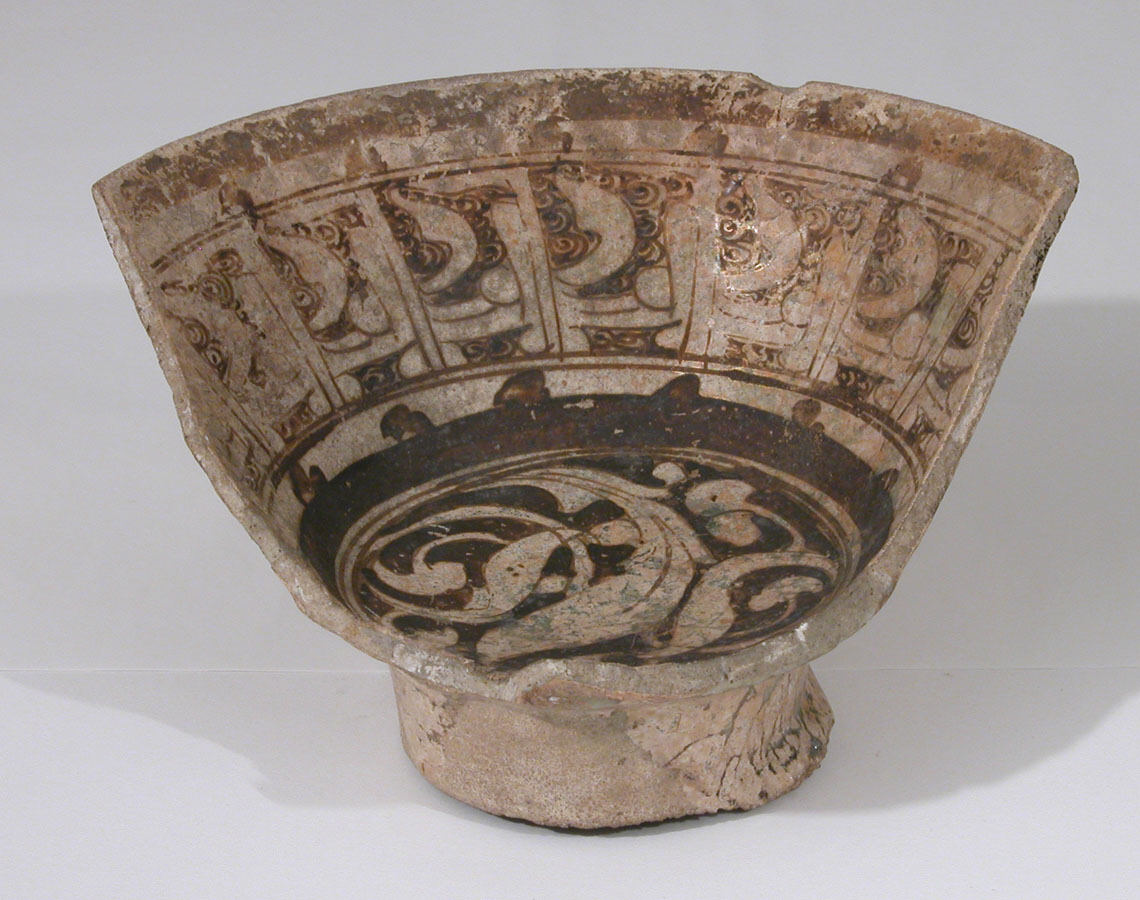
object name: fragment of a bowl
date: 1101-1300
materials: stonepaste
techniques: luster painting, underglaze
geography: syria